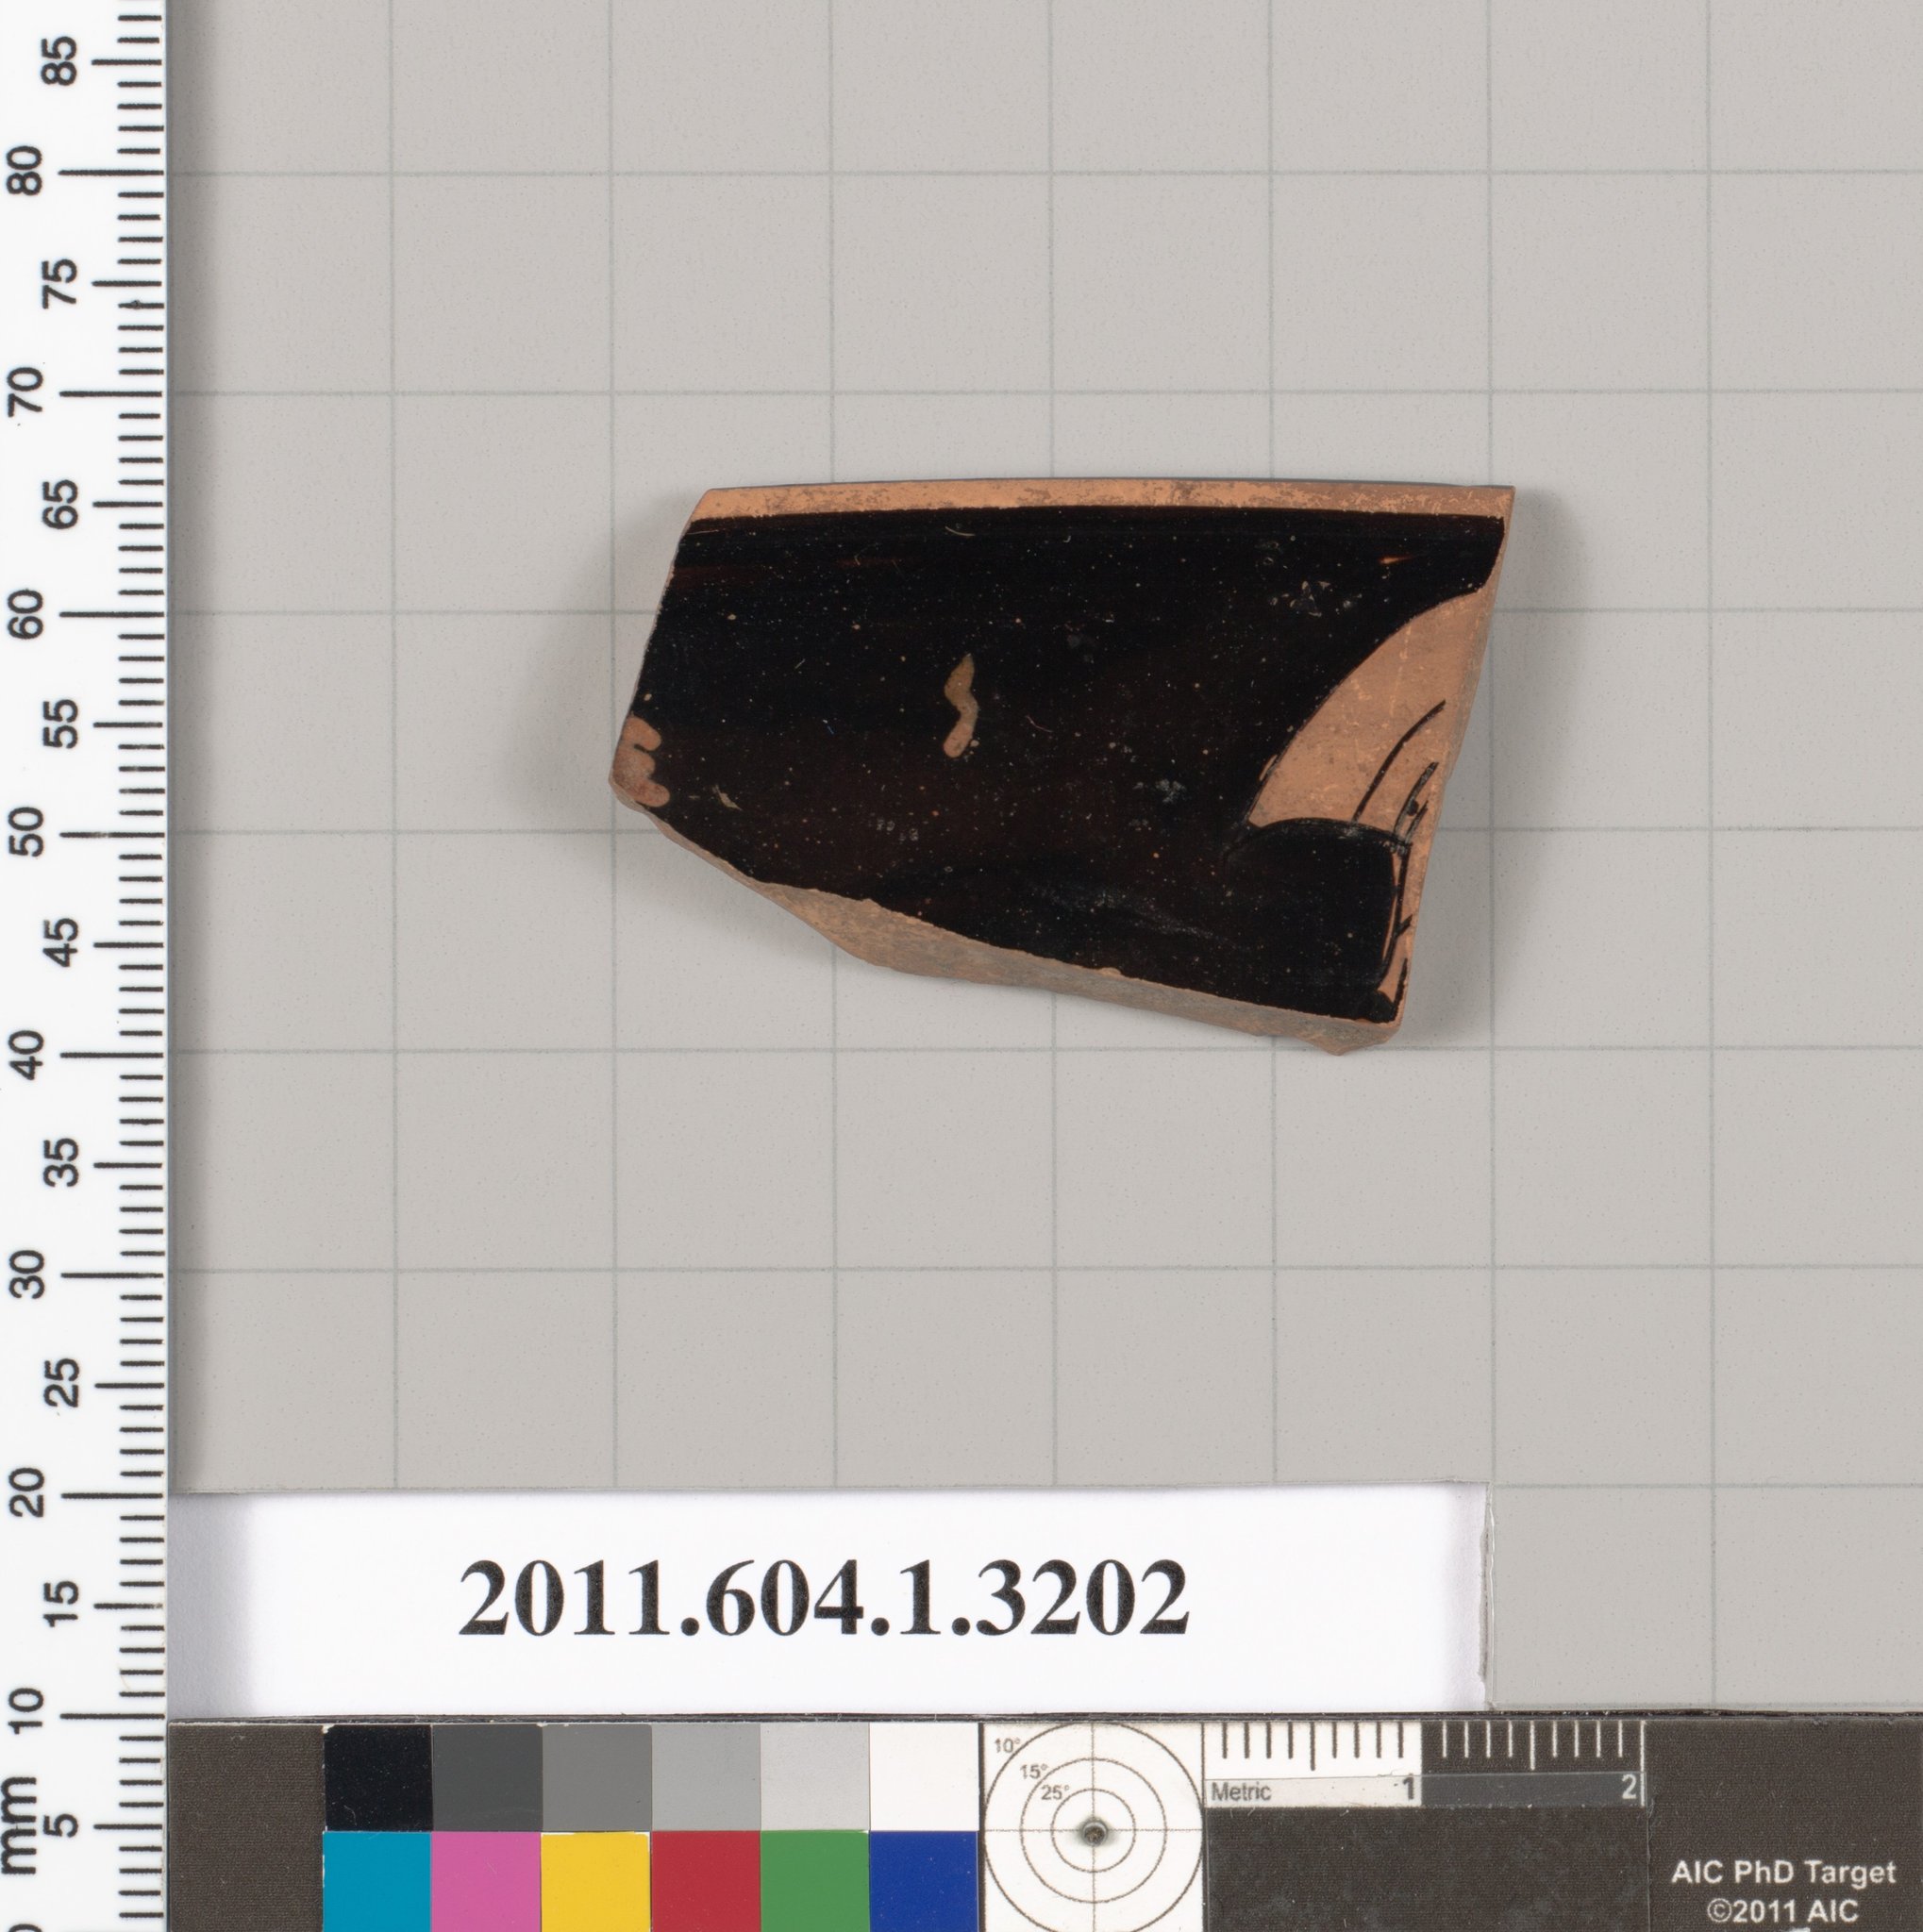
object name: kylix fragment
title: Terracotta rim fragment of a kylix (drinking cup)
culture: greek, attic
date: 520-500 BCE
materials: terracotta